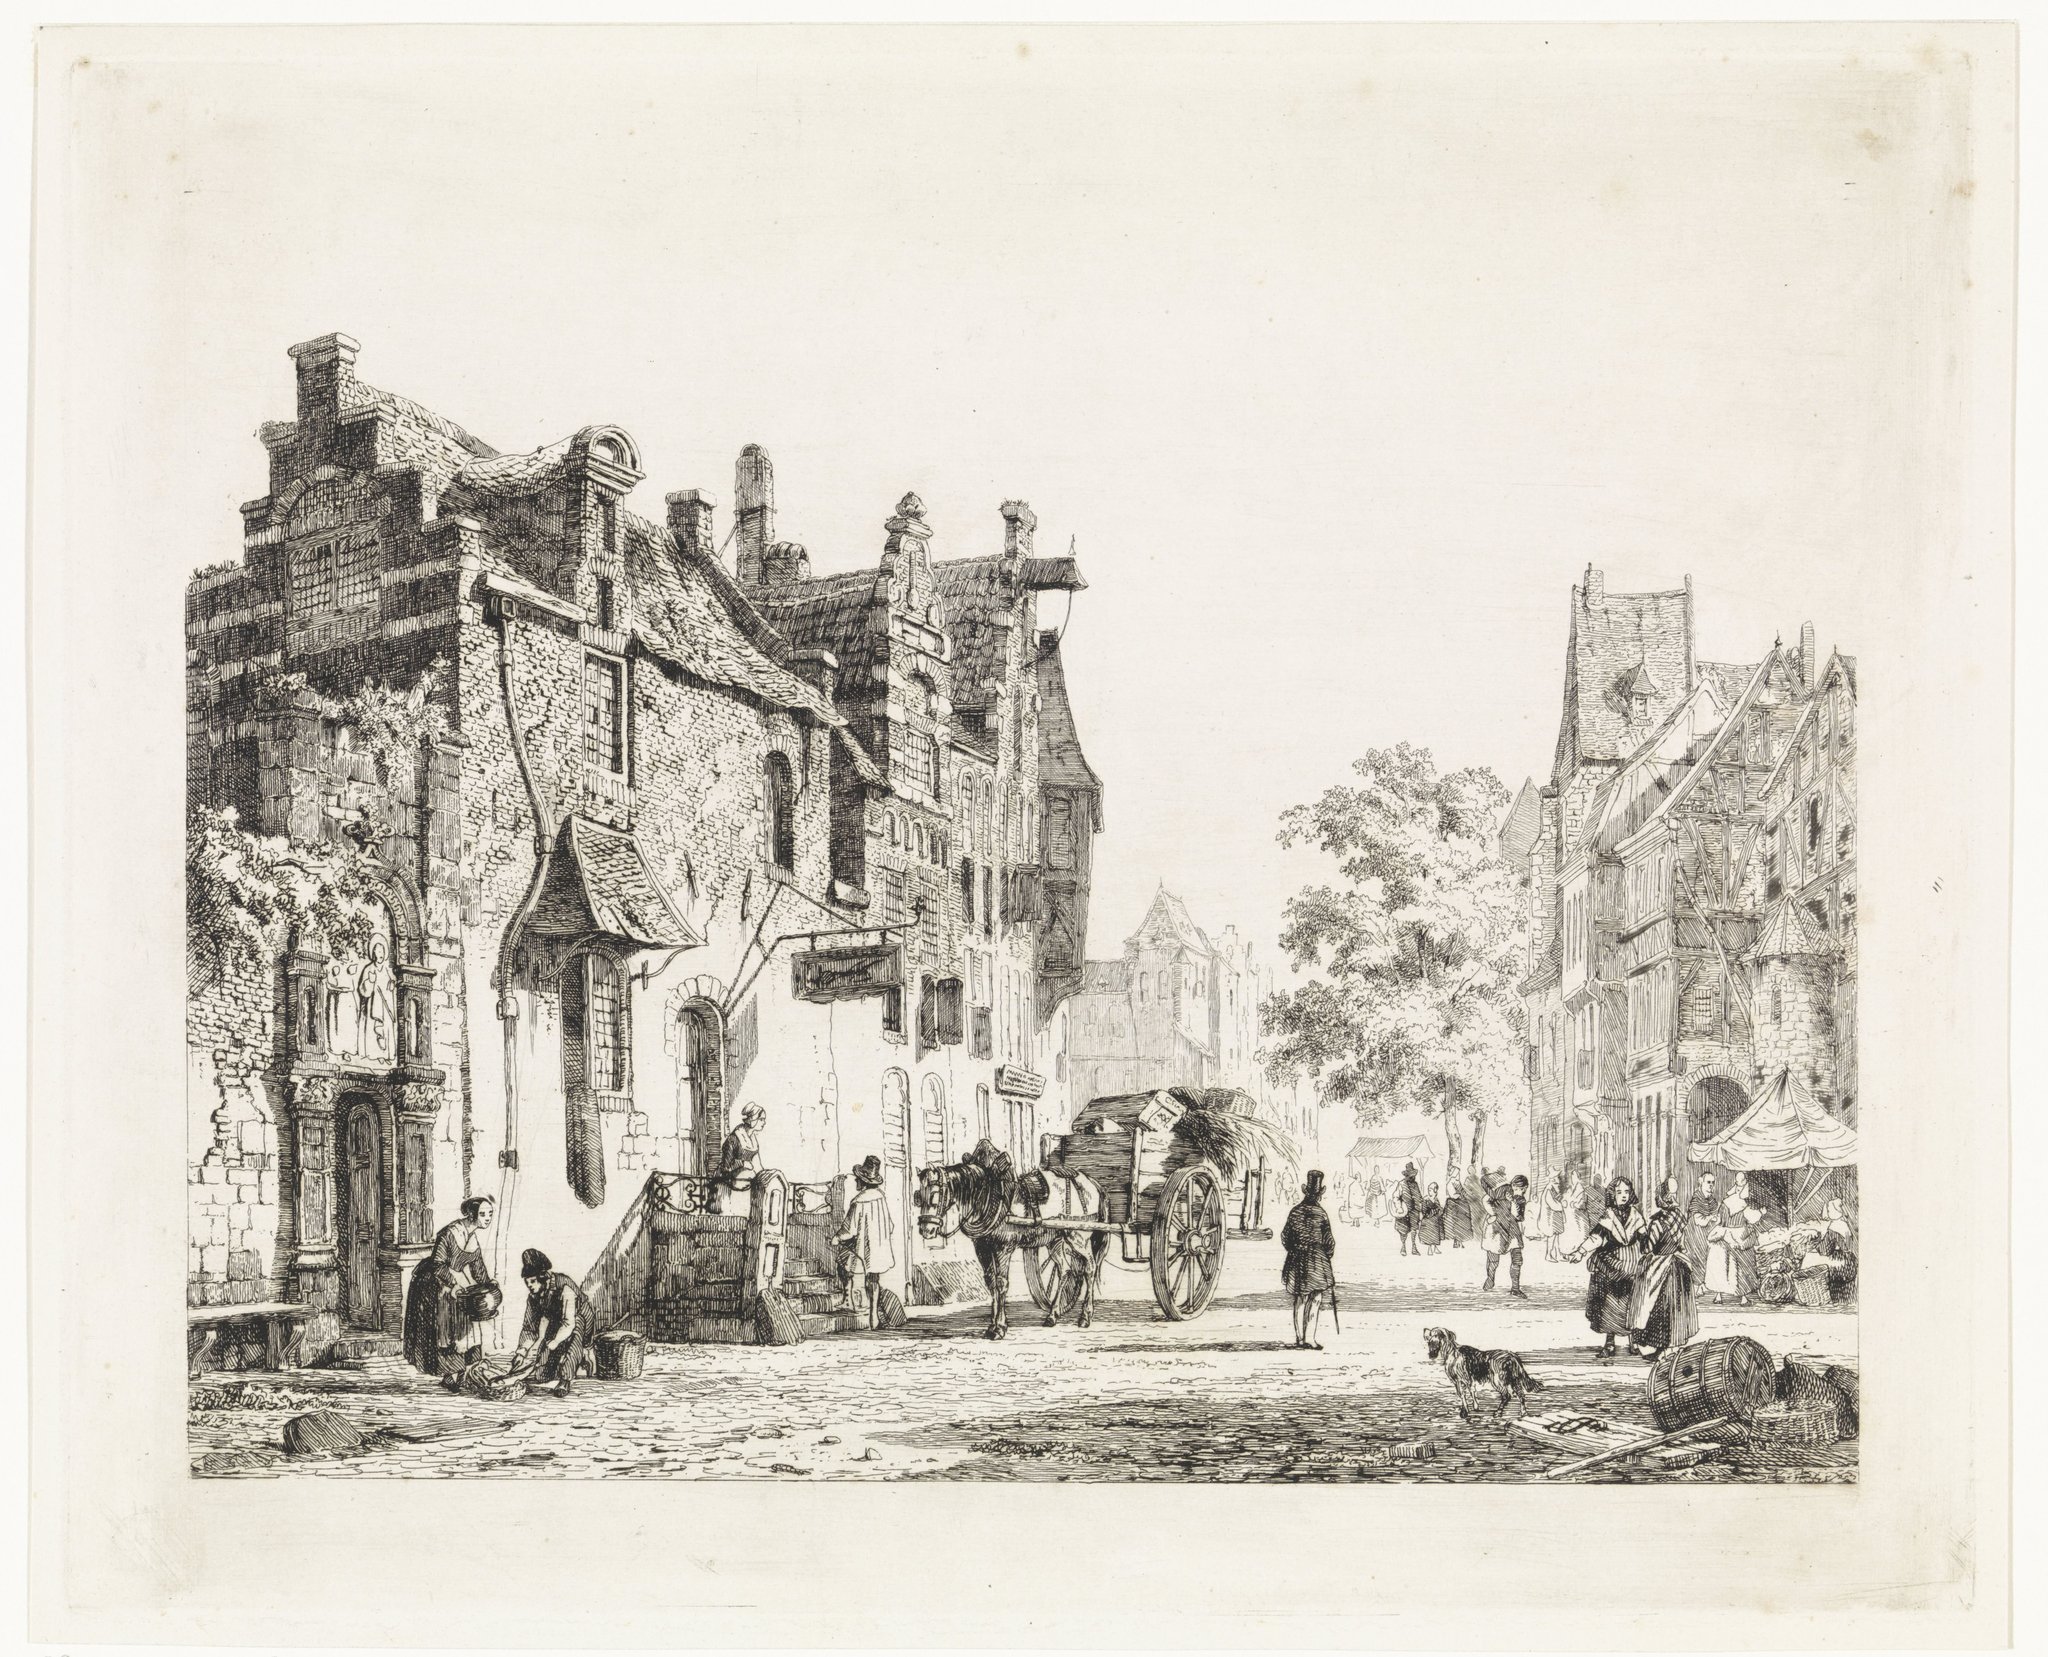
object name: print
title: Stadsgezicht met paardenkar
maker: cornelis springer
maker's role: draughtsman, painter, print maker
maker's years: 1817-1891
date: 1845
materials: paper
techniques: etching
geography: amsterdam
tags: two-wheeled vehicle drawn by one animal, village street (+ city(-scape) with figures, staffage)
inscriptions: collector's mark: Lugt 2228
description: Stadsgezicht met op straat mensen en een volgeladen paardenkar.